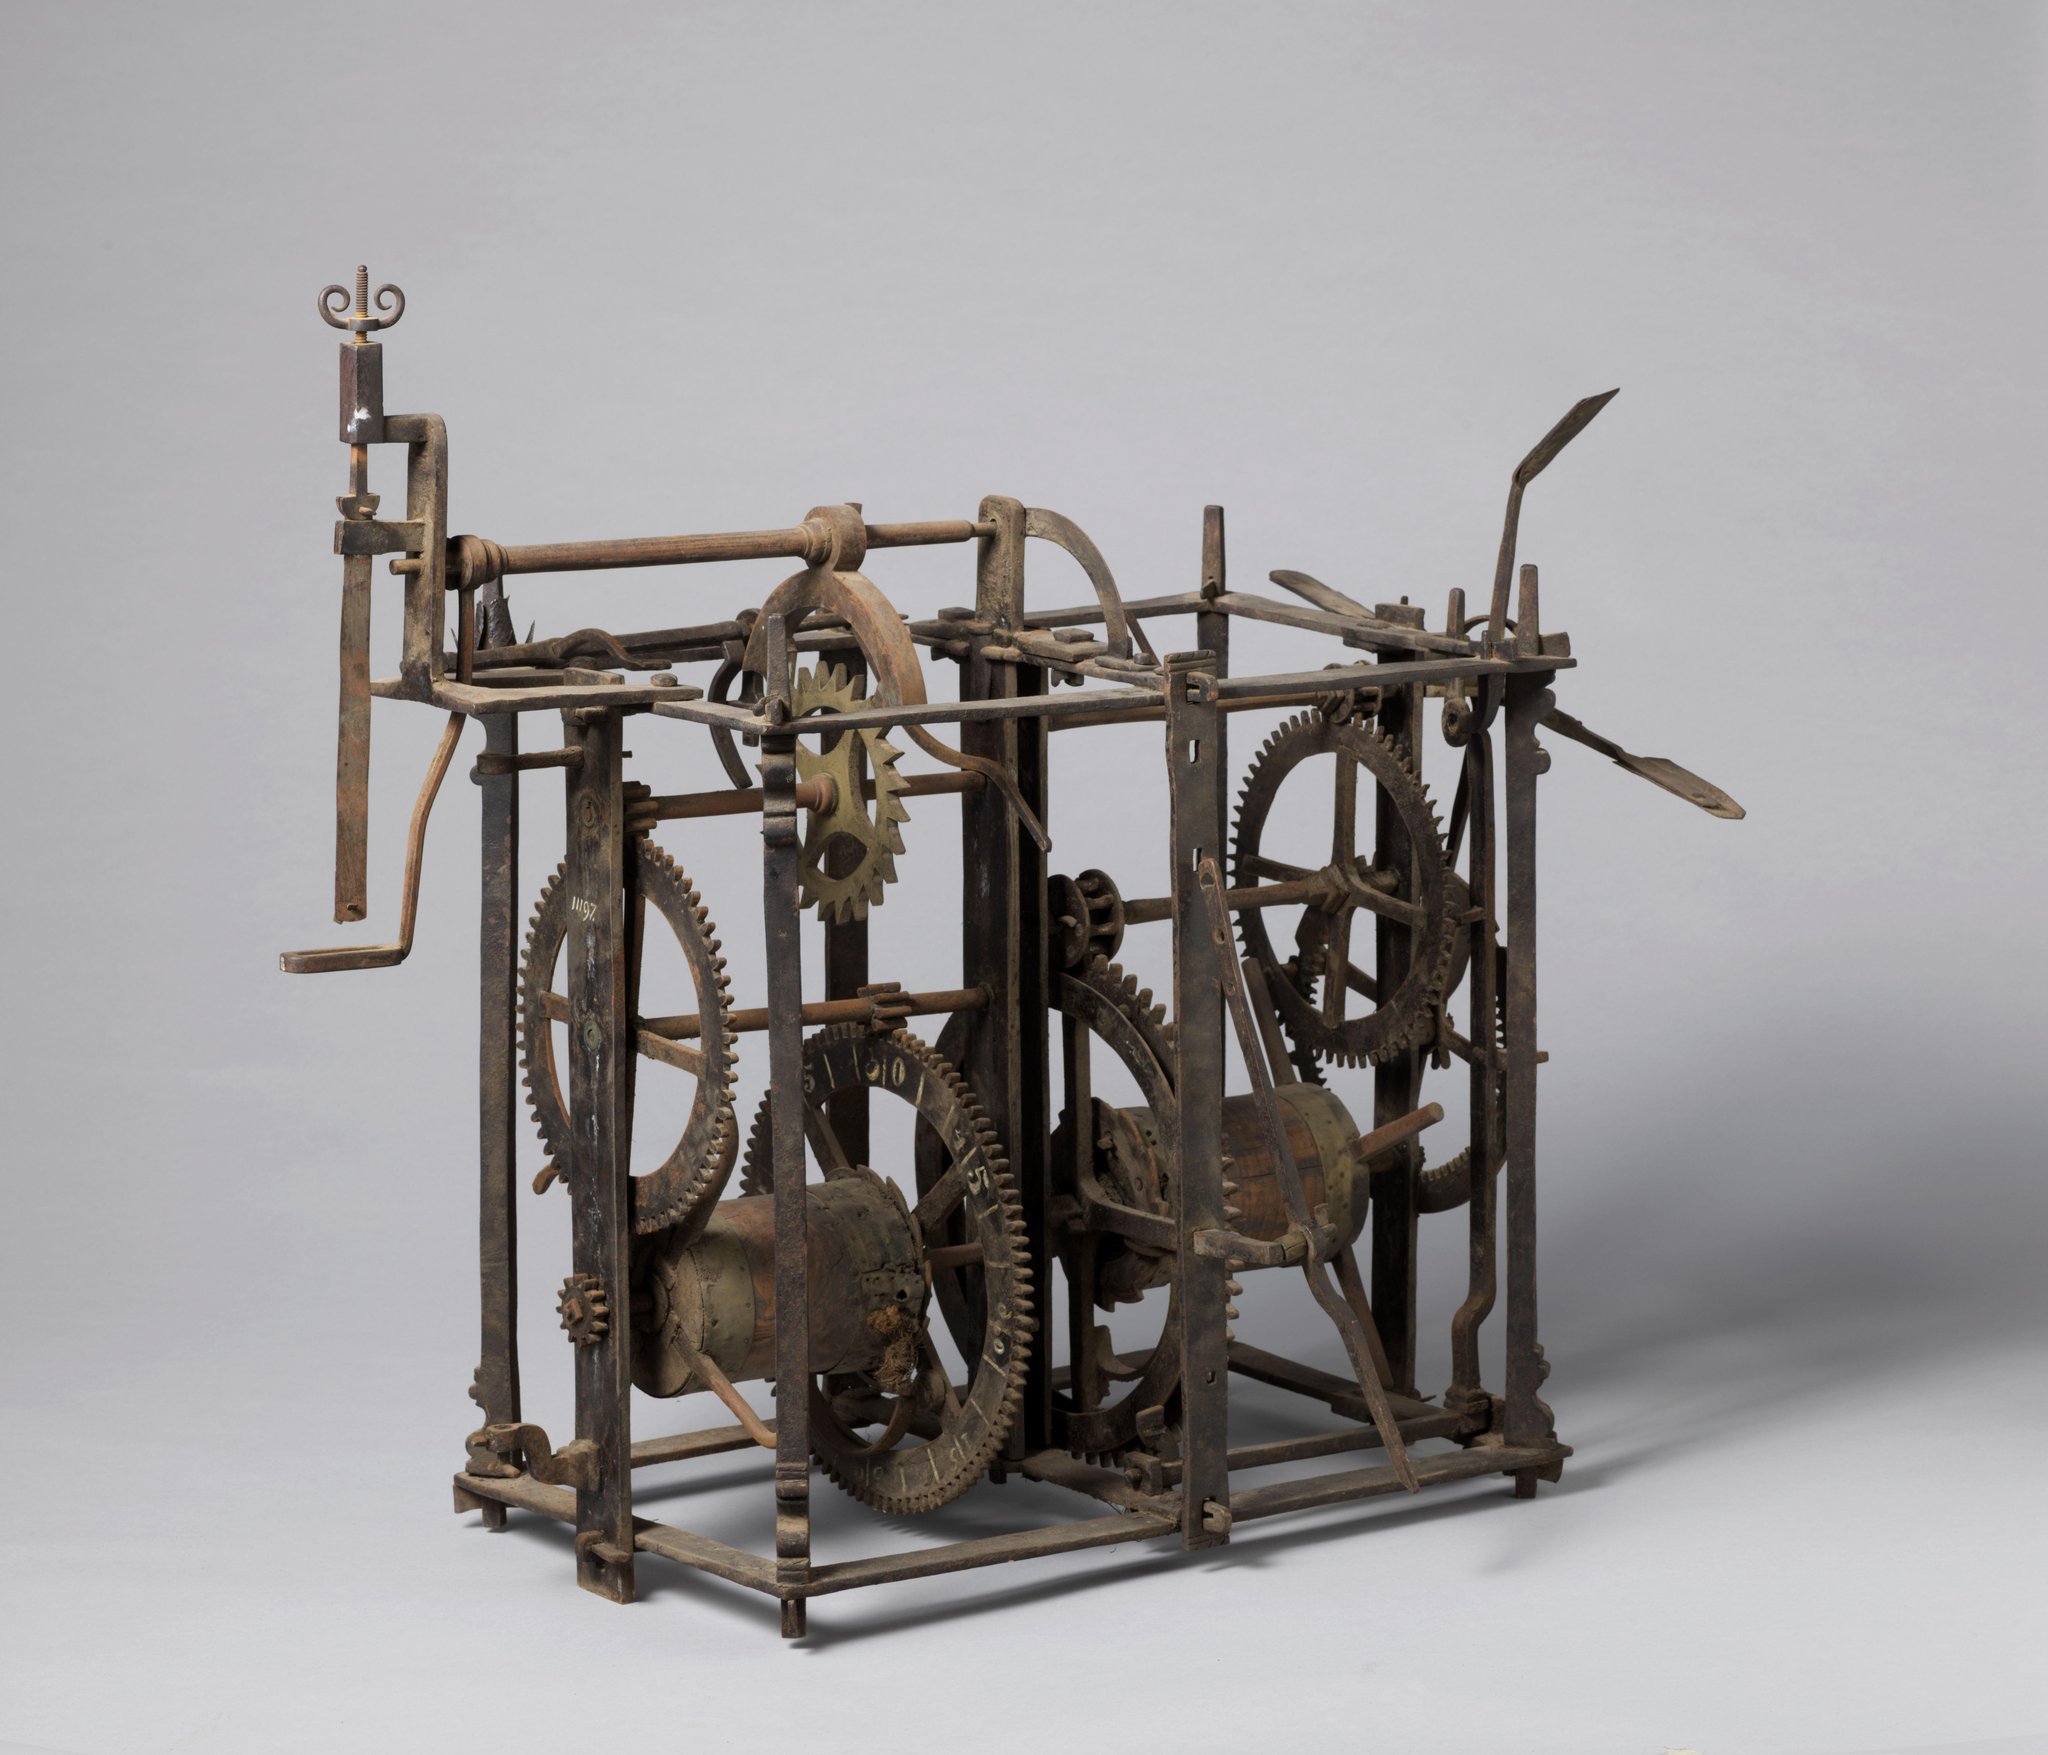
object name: gear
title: Rad op as van het torenuurwerk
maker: Anonymous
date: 1585-1615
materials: iron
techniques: forging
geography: northern netherlands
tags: waterpoort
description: Rad op as van het torenuurwerk afkomstig van de afgebroken Waterpoort te Gorinchem.